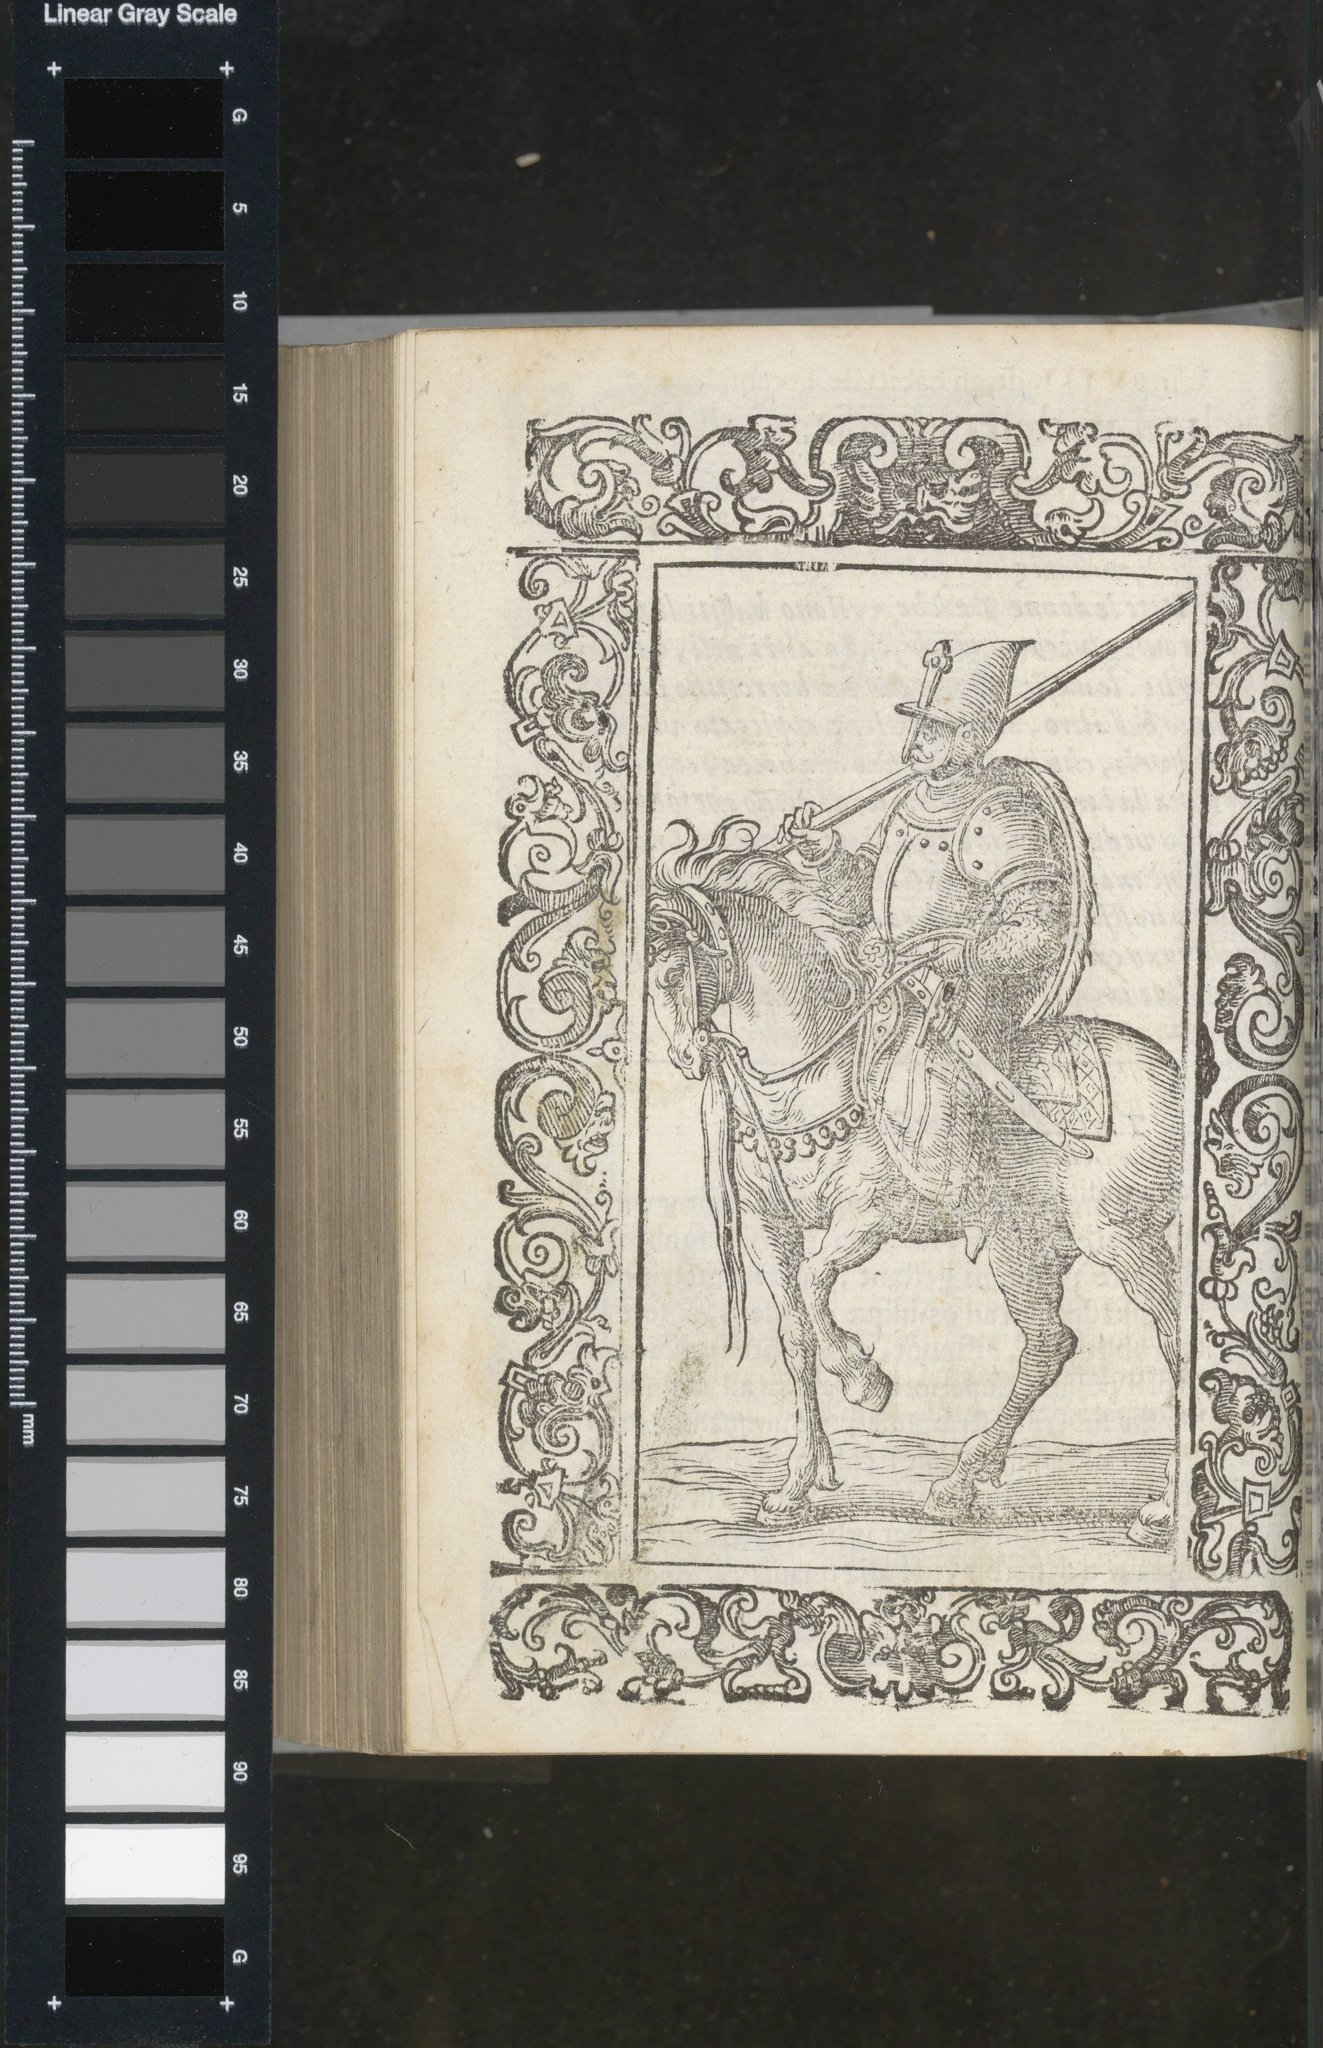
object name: costume print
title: Habiti antichi, et moderni di tutto il mondo...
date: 1598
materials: paper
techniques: woodcut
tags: fashion plates